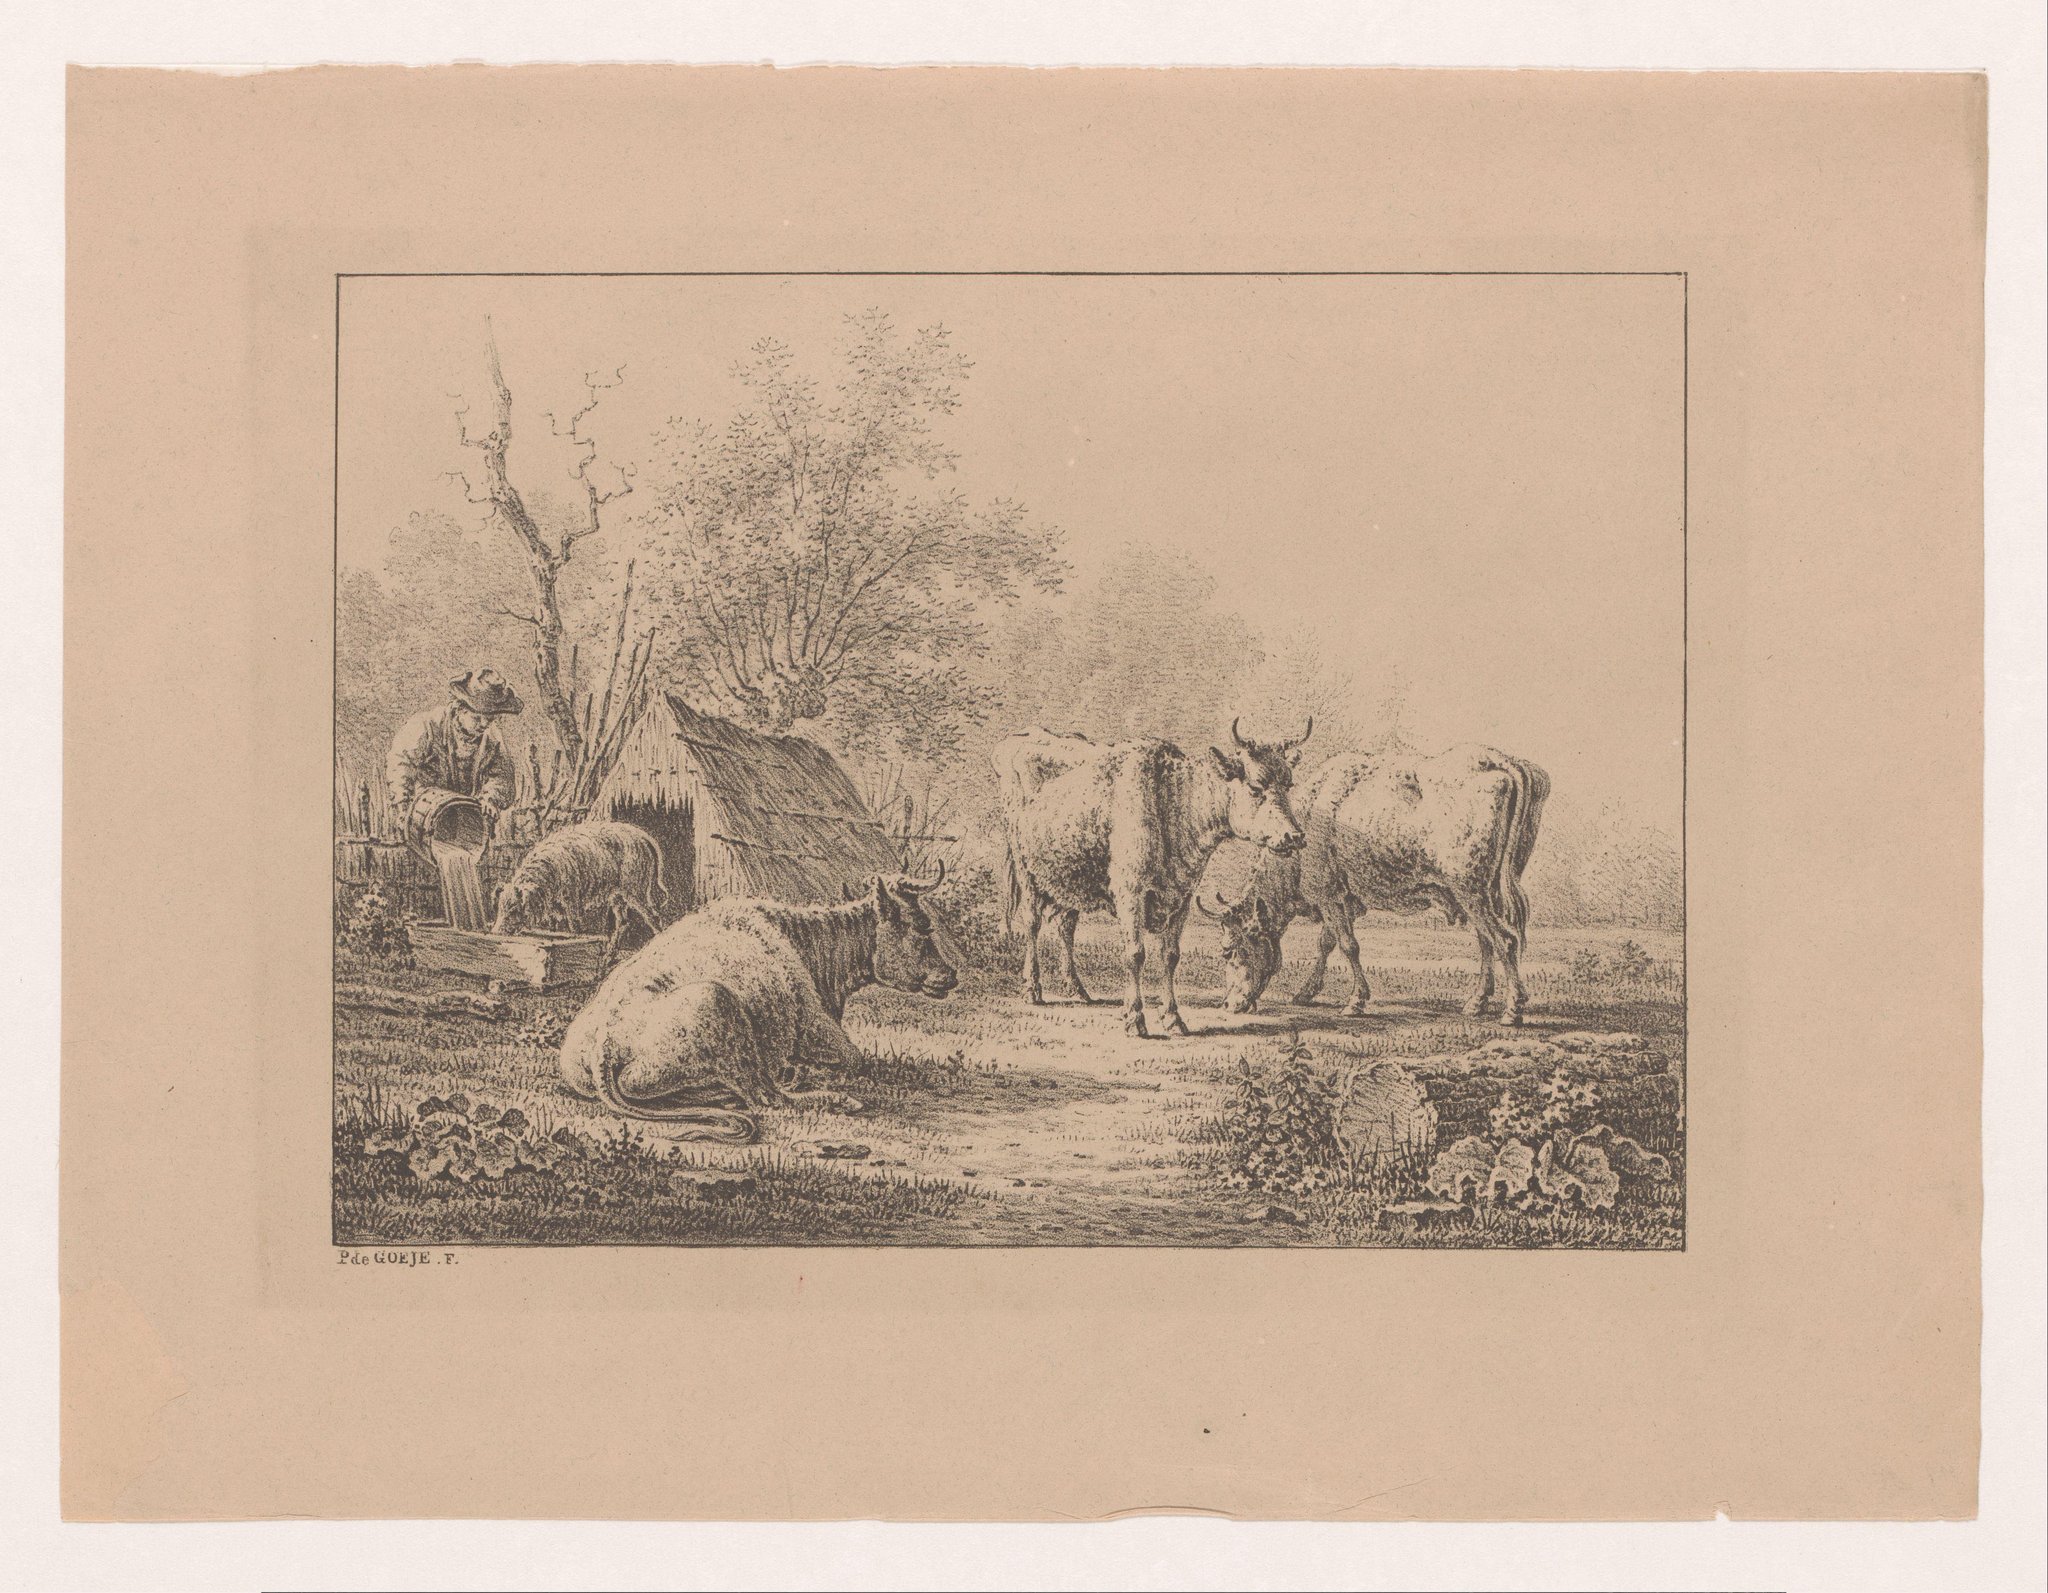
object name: print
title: Koeien en een schaap bij een hut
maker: pieter de goeje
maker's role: draughtsman, print maker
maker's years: 1789-1859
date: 1809-1859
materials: paper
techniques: tone lithography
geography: netherlands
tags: cow, sheep (+ animals eating and drinking), meadow, pasture, sheep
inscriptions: collector's mark: Lugt 2228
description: Een man giet water in de drinkbak van de dieren terwijl het schaap eruit drinkt.